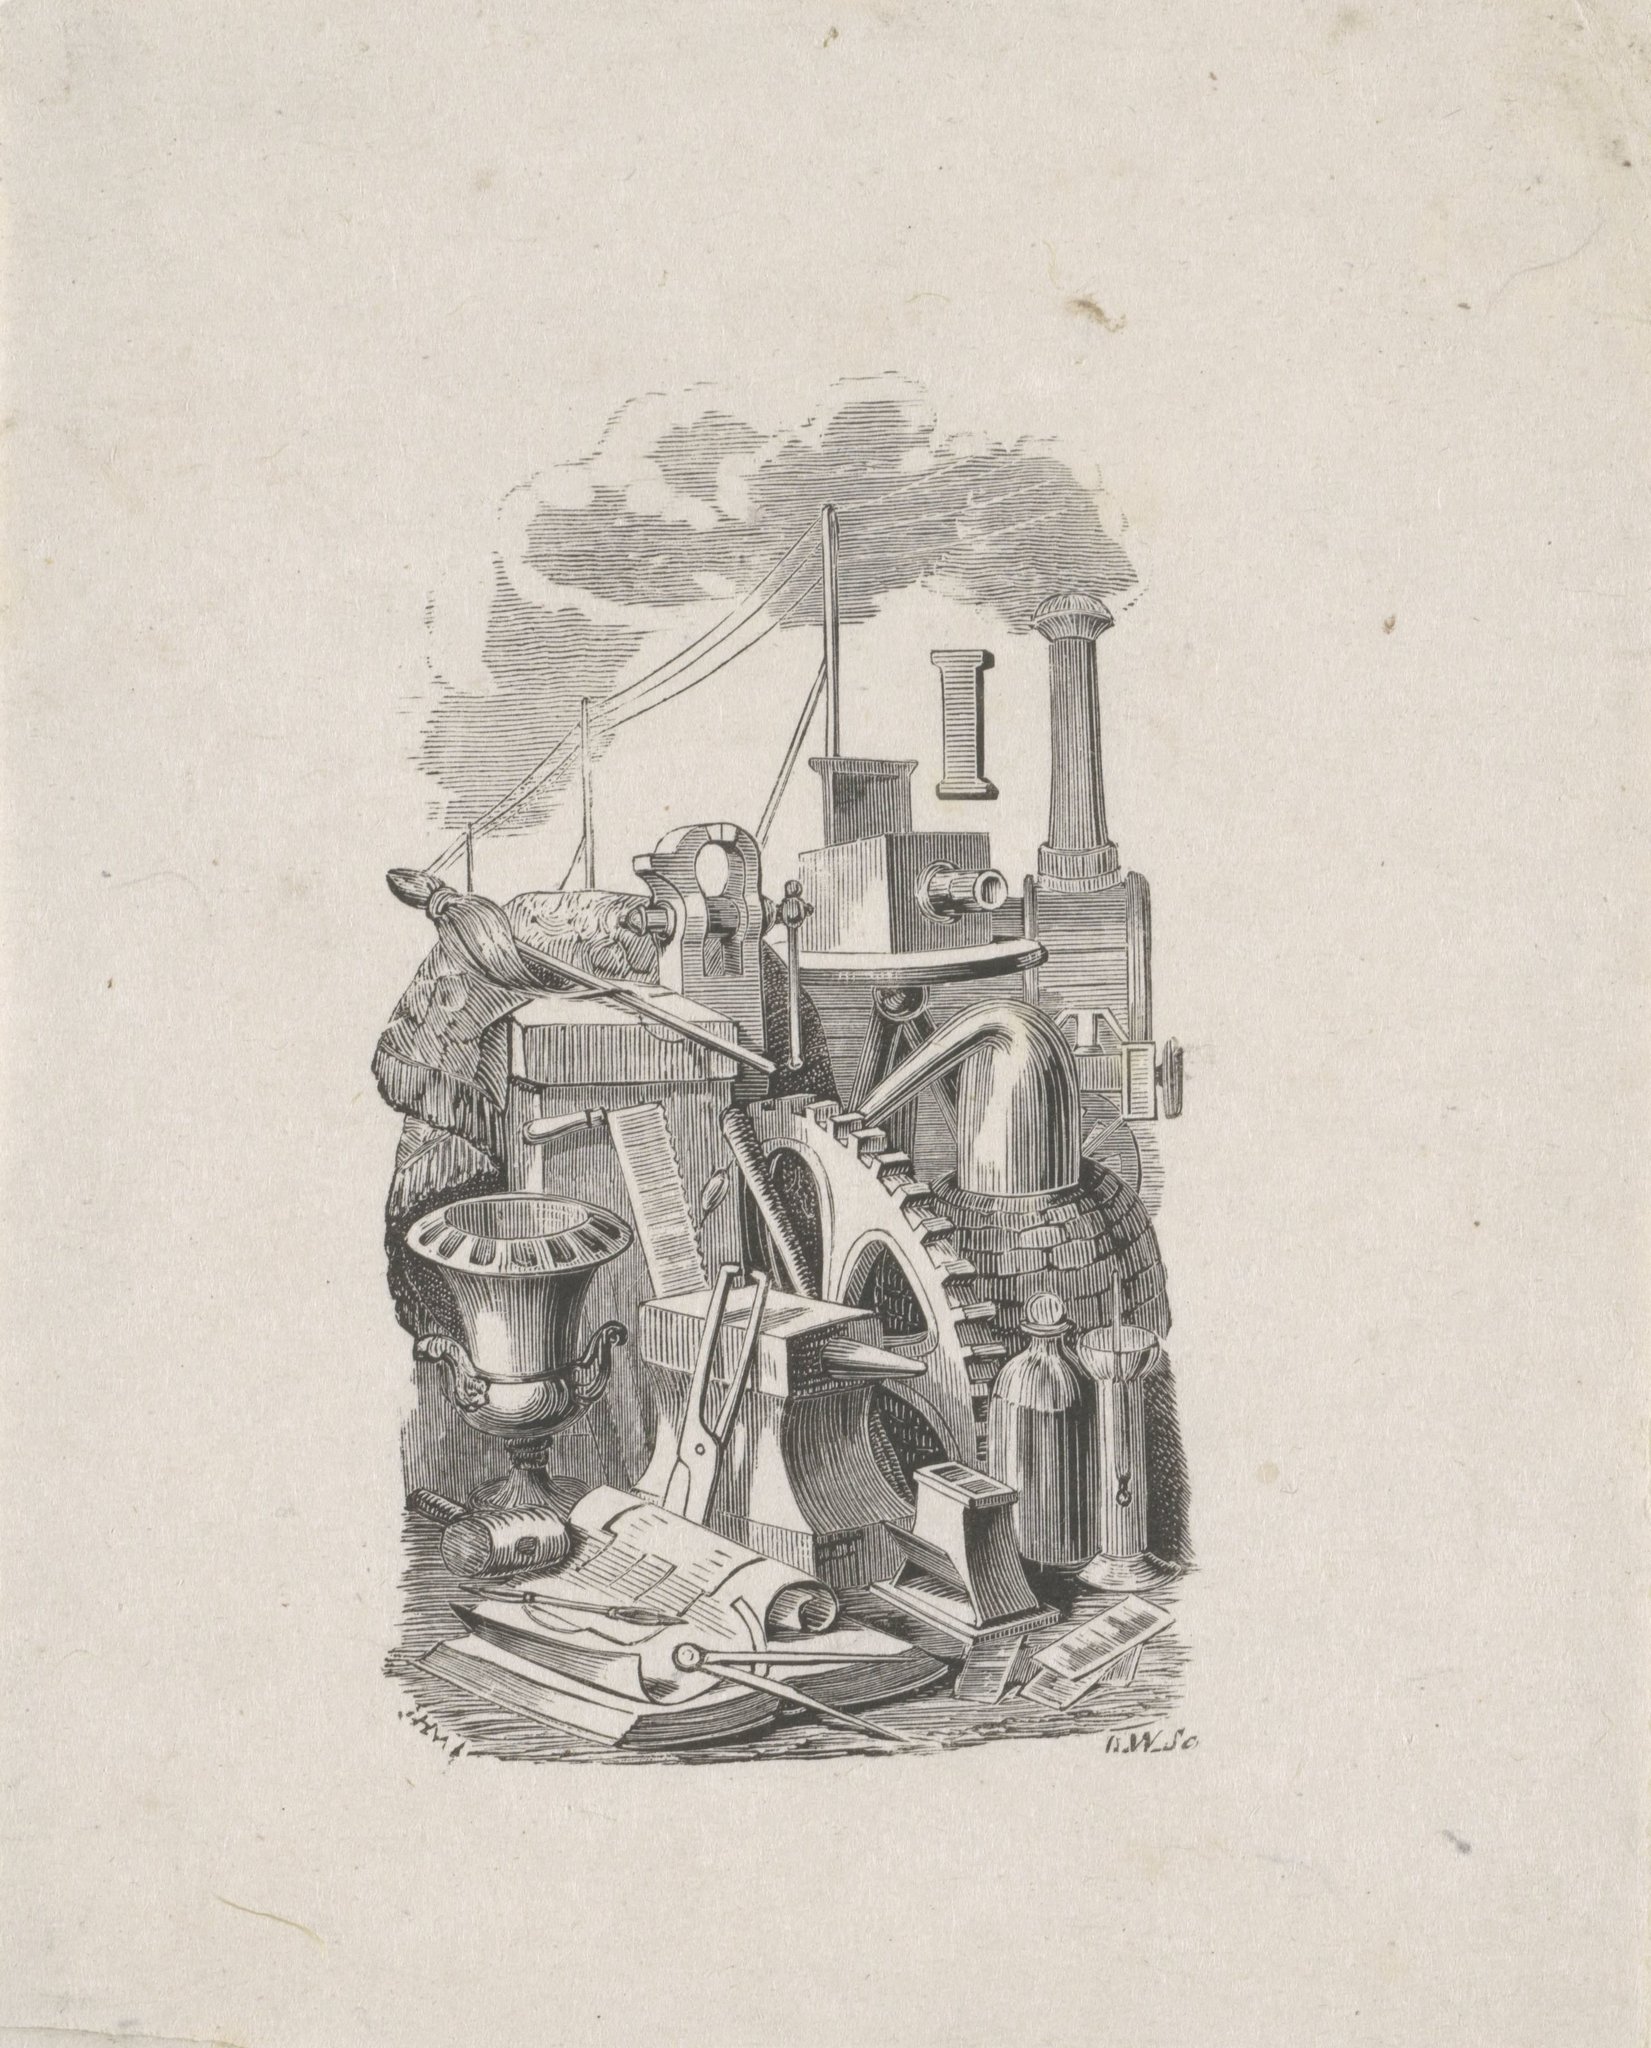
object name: print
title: Letter I en een aantal objecten uit de negentiende eeuw, waaronder een tandwiel en een stoomlocomotief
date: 1836-1912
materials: paper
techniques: engraving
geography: netherlands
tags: fancy letters, steam locomotive